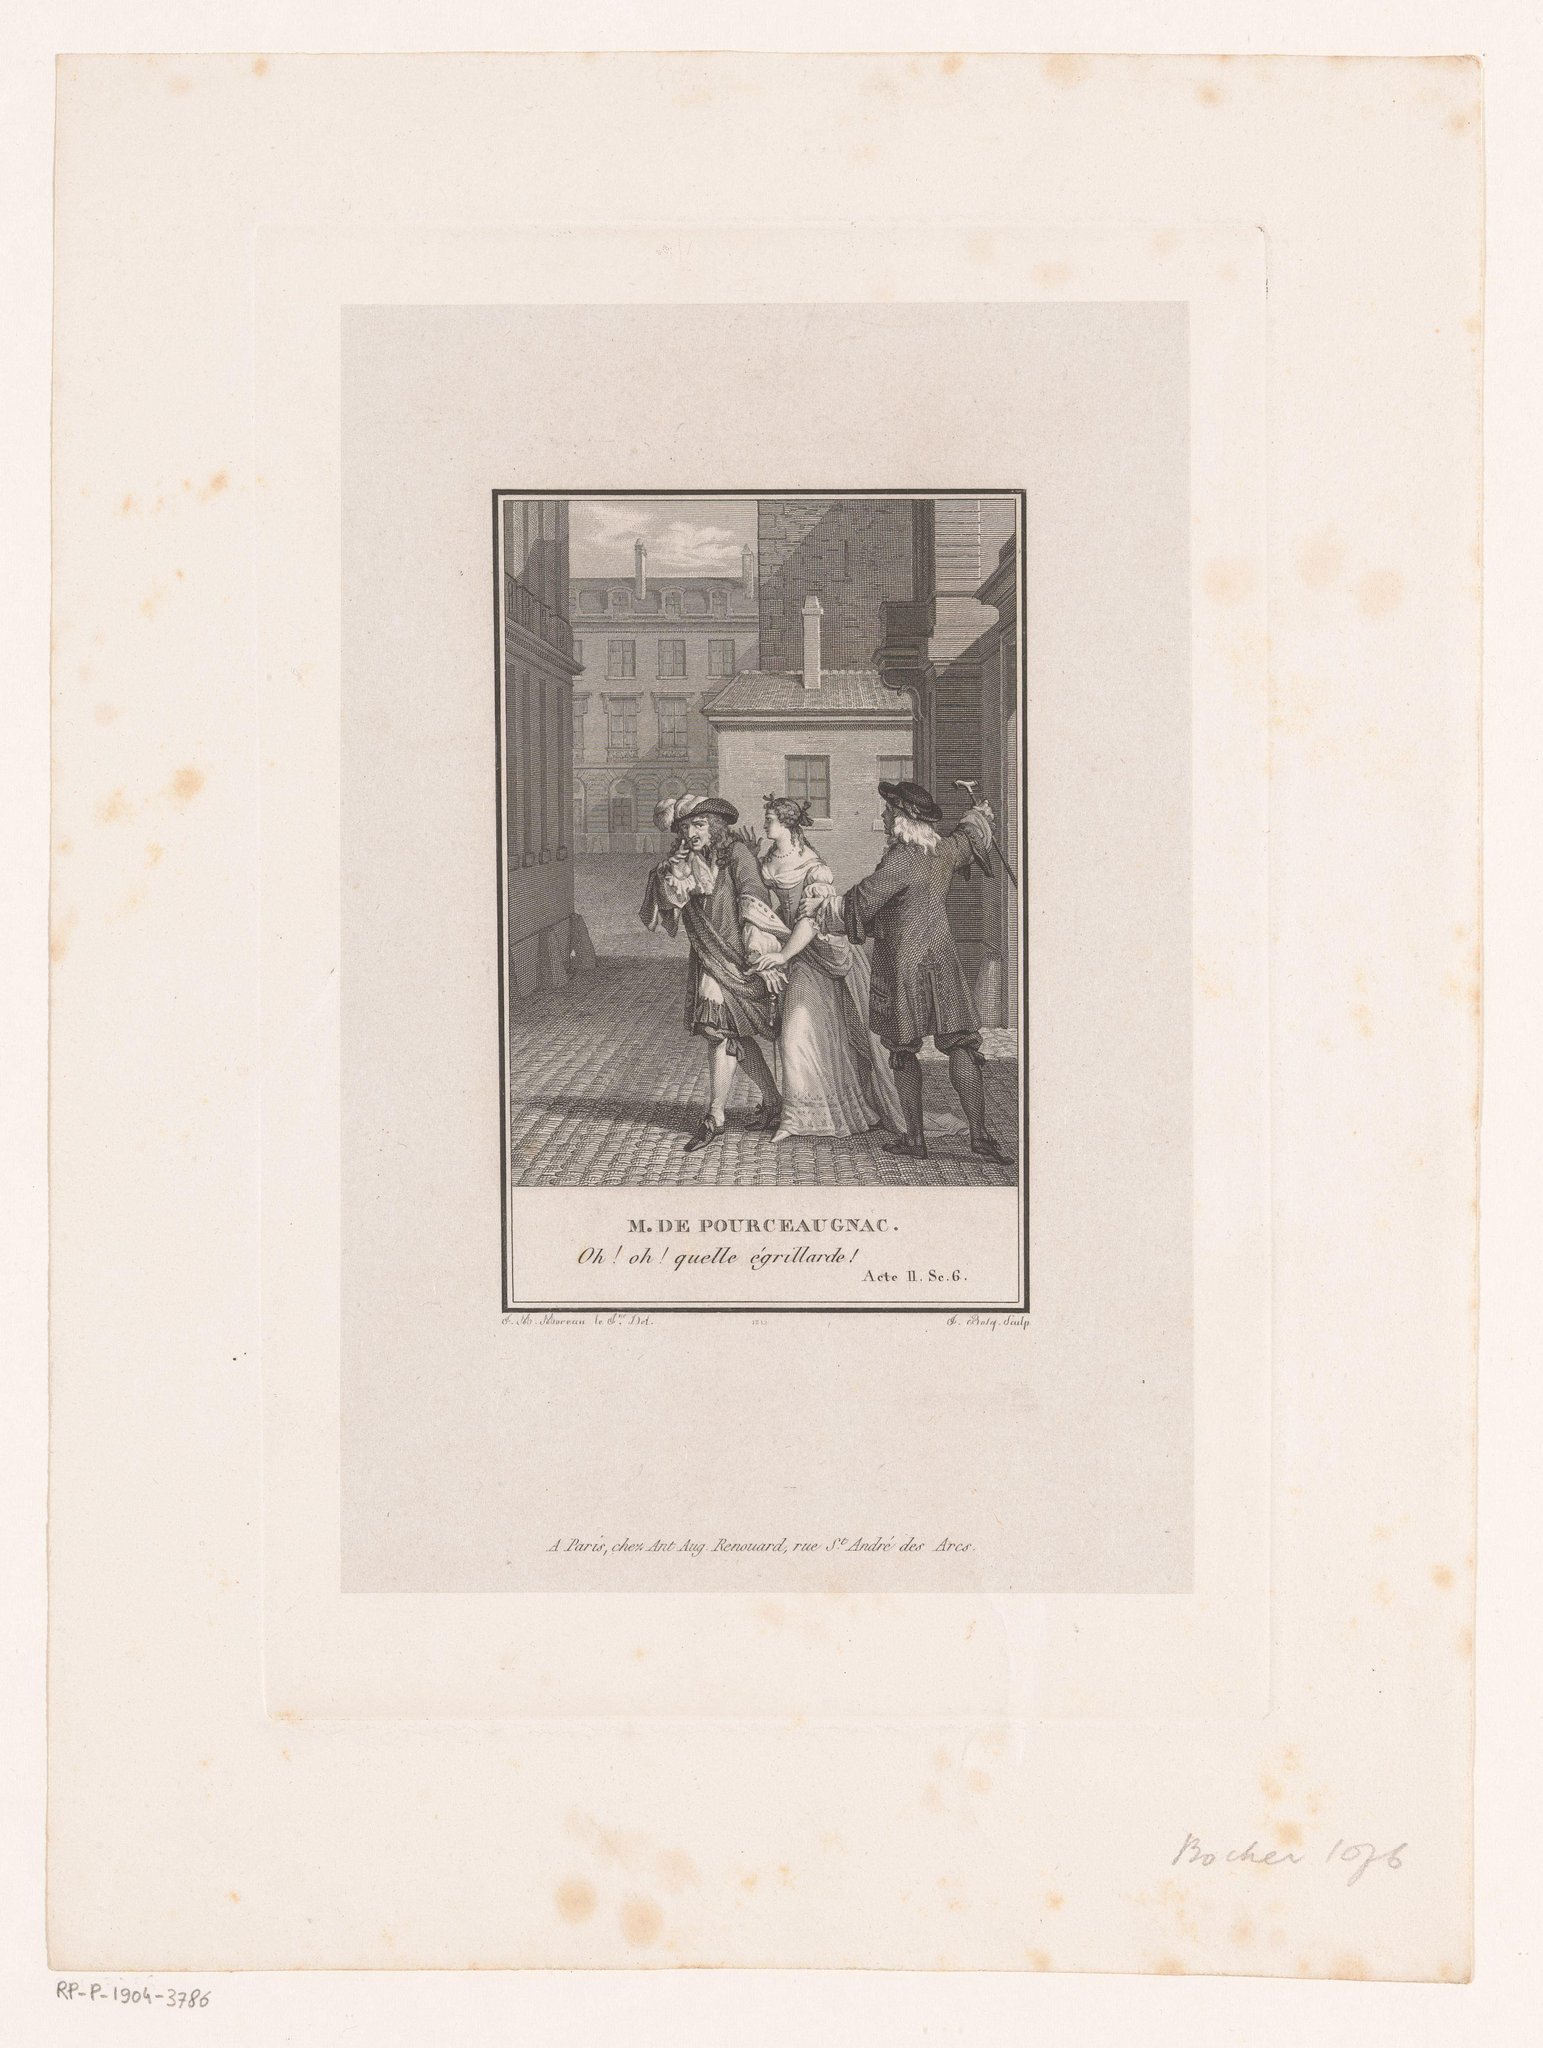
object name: print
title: Jonge vrouw met edelman, tegengehouden door haar vader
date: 1811-1813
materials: paper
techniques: engraving, etching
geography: paris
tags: father and daughter(s) (family group), theatre, theatrical performance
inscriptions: collector's mark: Lugt 2228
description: Prent van scène zes uit de tweede acte van 'Mr de Pourceaugnac' door Jean Baptiste Molière. Dit betreft een van de dertig prenten, gemaakt in opdracht van Antoine Augustin Renouard, bestemd voor verschillende edities van Molières werk daterend van 1811 tot 1813. De prenten zijn vervaardigd door verschillende kunstenaars naar composities van Moreau.